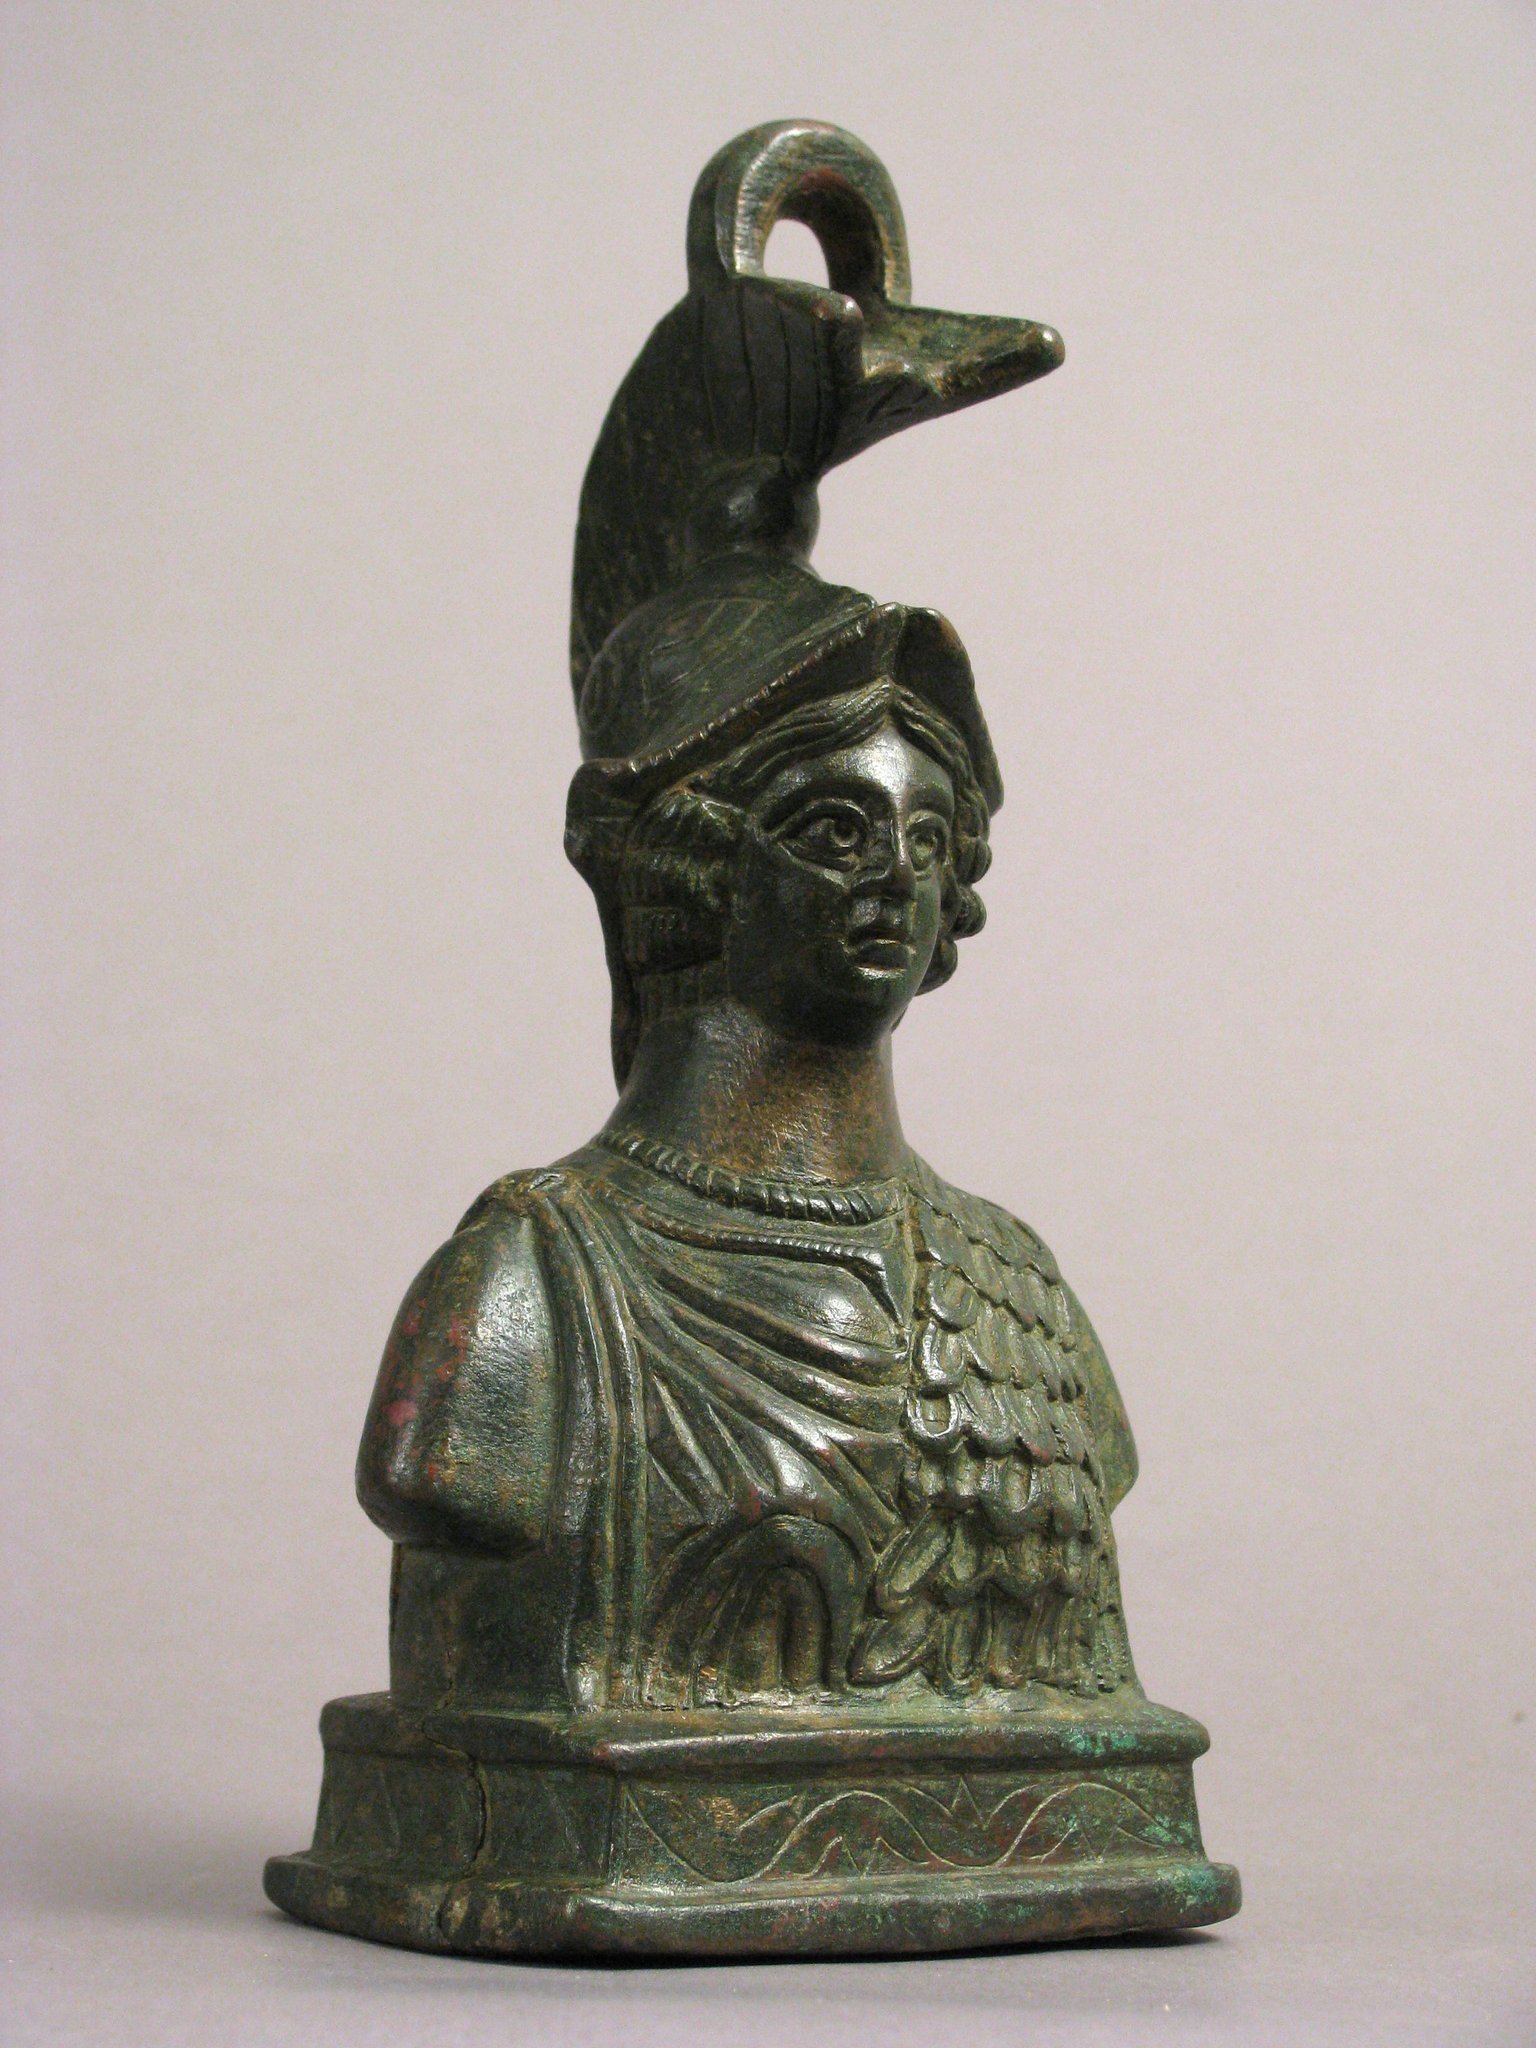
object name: steelyard weight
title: Steelyard Weight with the Bust of Athena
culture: byzantine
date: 350-500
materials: copper alloy, lead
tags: athena